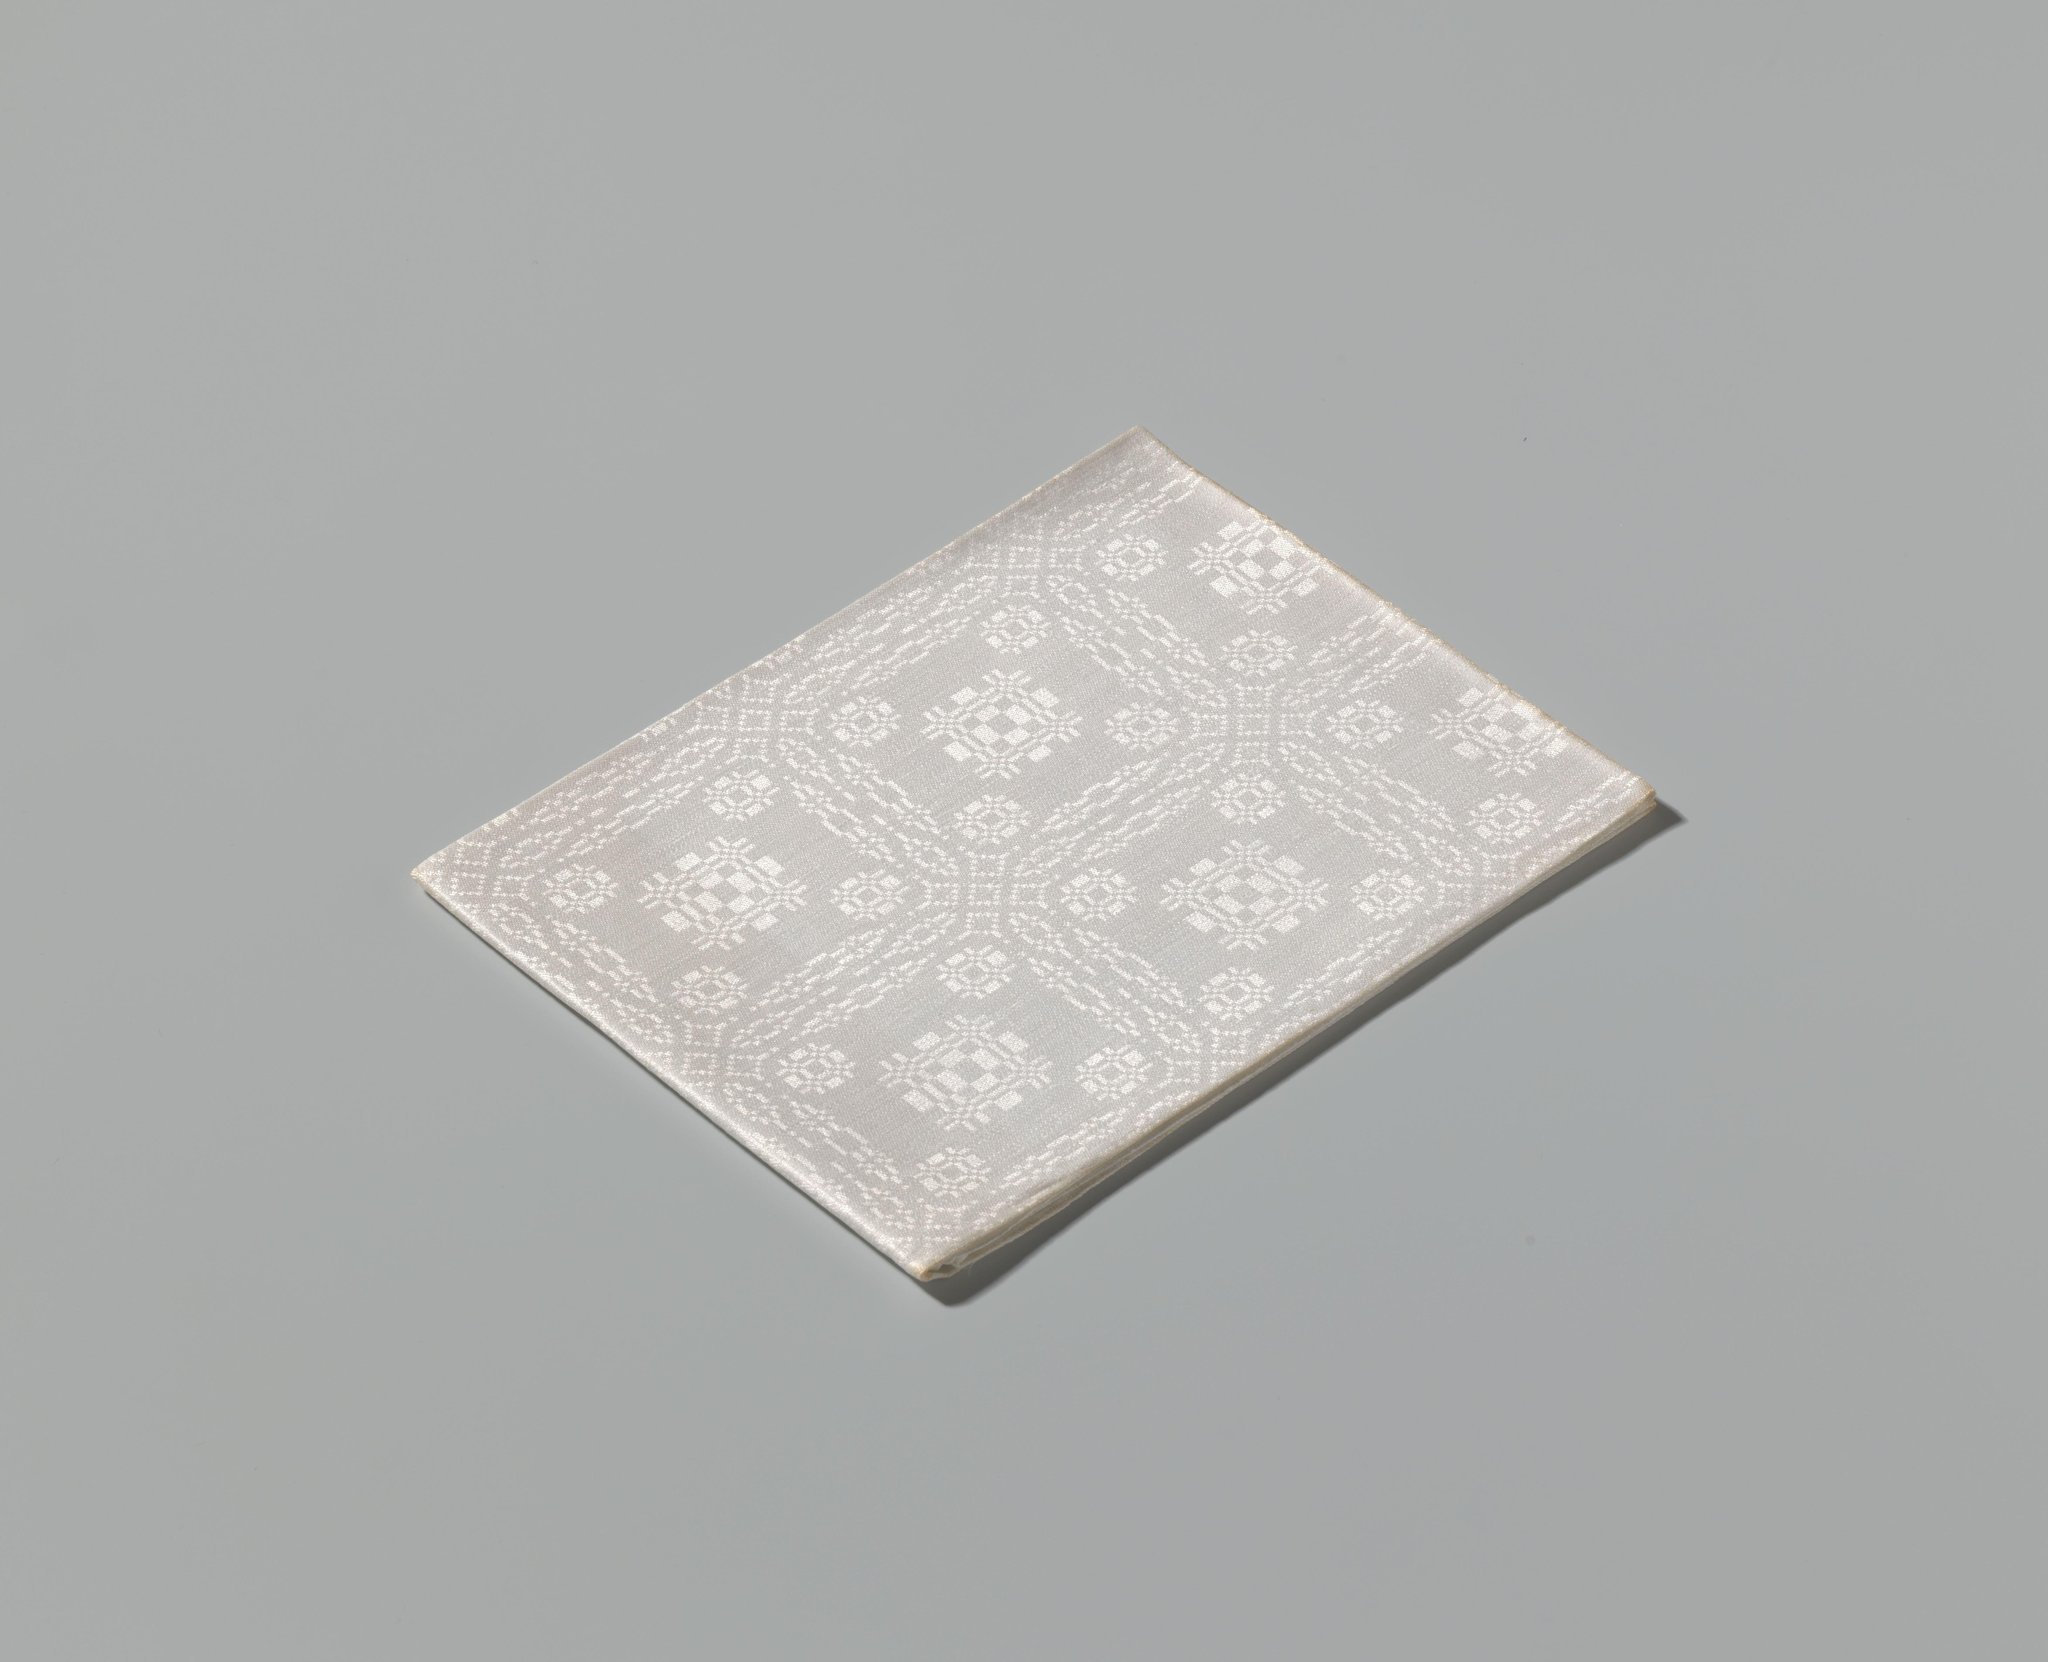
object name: napkin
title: Servet van linnen met pellenpatroon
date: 1690-1710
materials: linen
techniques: peeled fabric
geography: northern netherlands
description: wit linnen servet met pellen patroon, merk kroon G 36